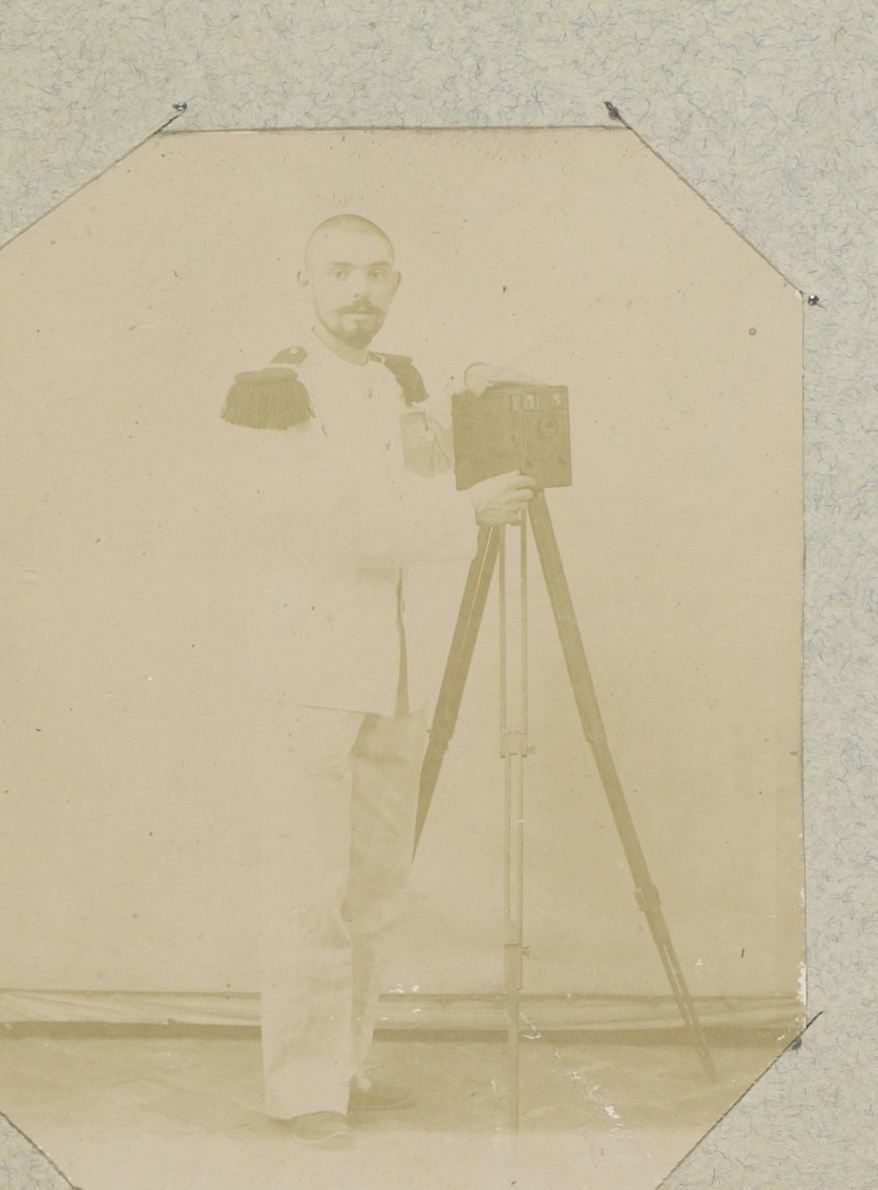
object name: album leaf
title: Portret van een man in een uniform met tressen staand naast een camera op een driepoot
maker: Anonymous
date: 1880-1900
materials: paper, photographic support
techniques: daylight paper print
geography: france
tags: studio ~ photographer, tripod, camera ~ photography, portrait, self-portrait of photographer, france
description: Onderdeel van Album van een Franse amateur met foto's van Frankrijk, Algerije, Palmyra, de Wereldtentoonstelling van 1900 en van bekende Fransen.